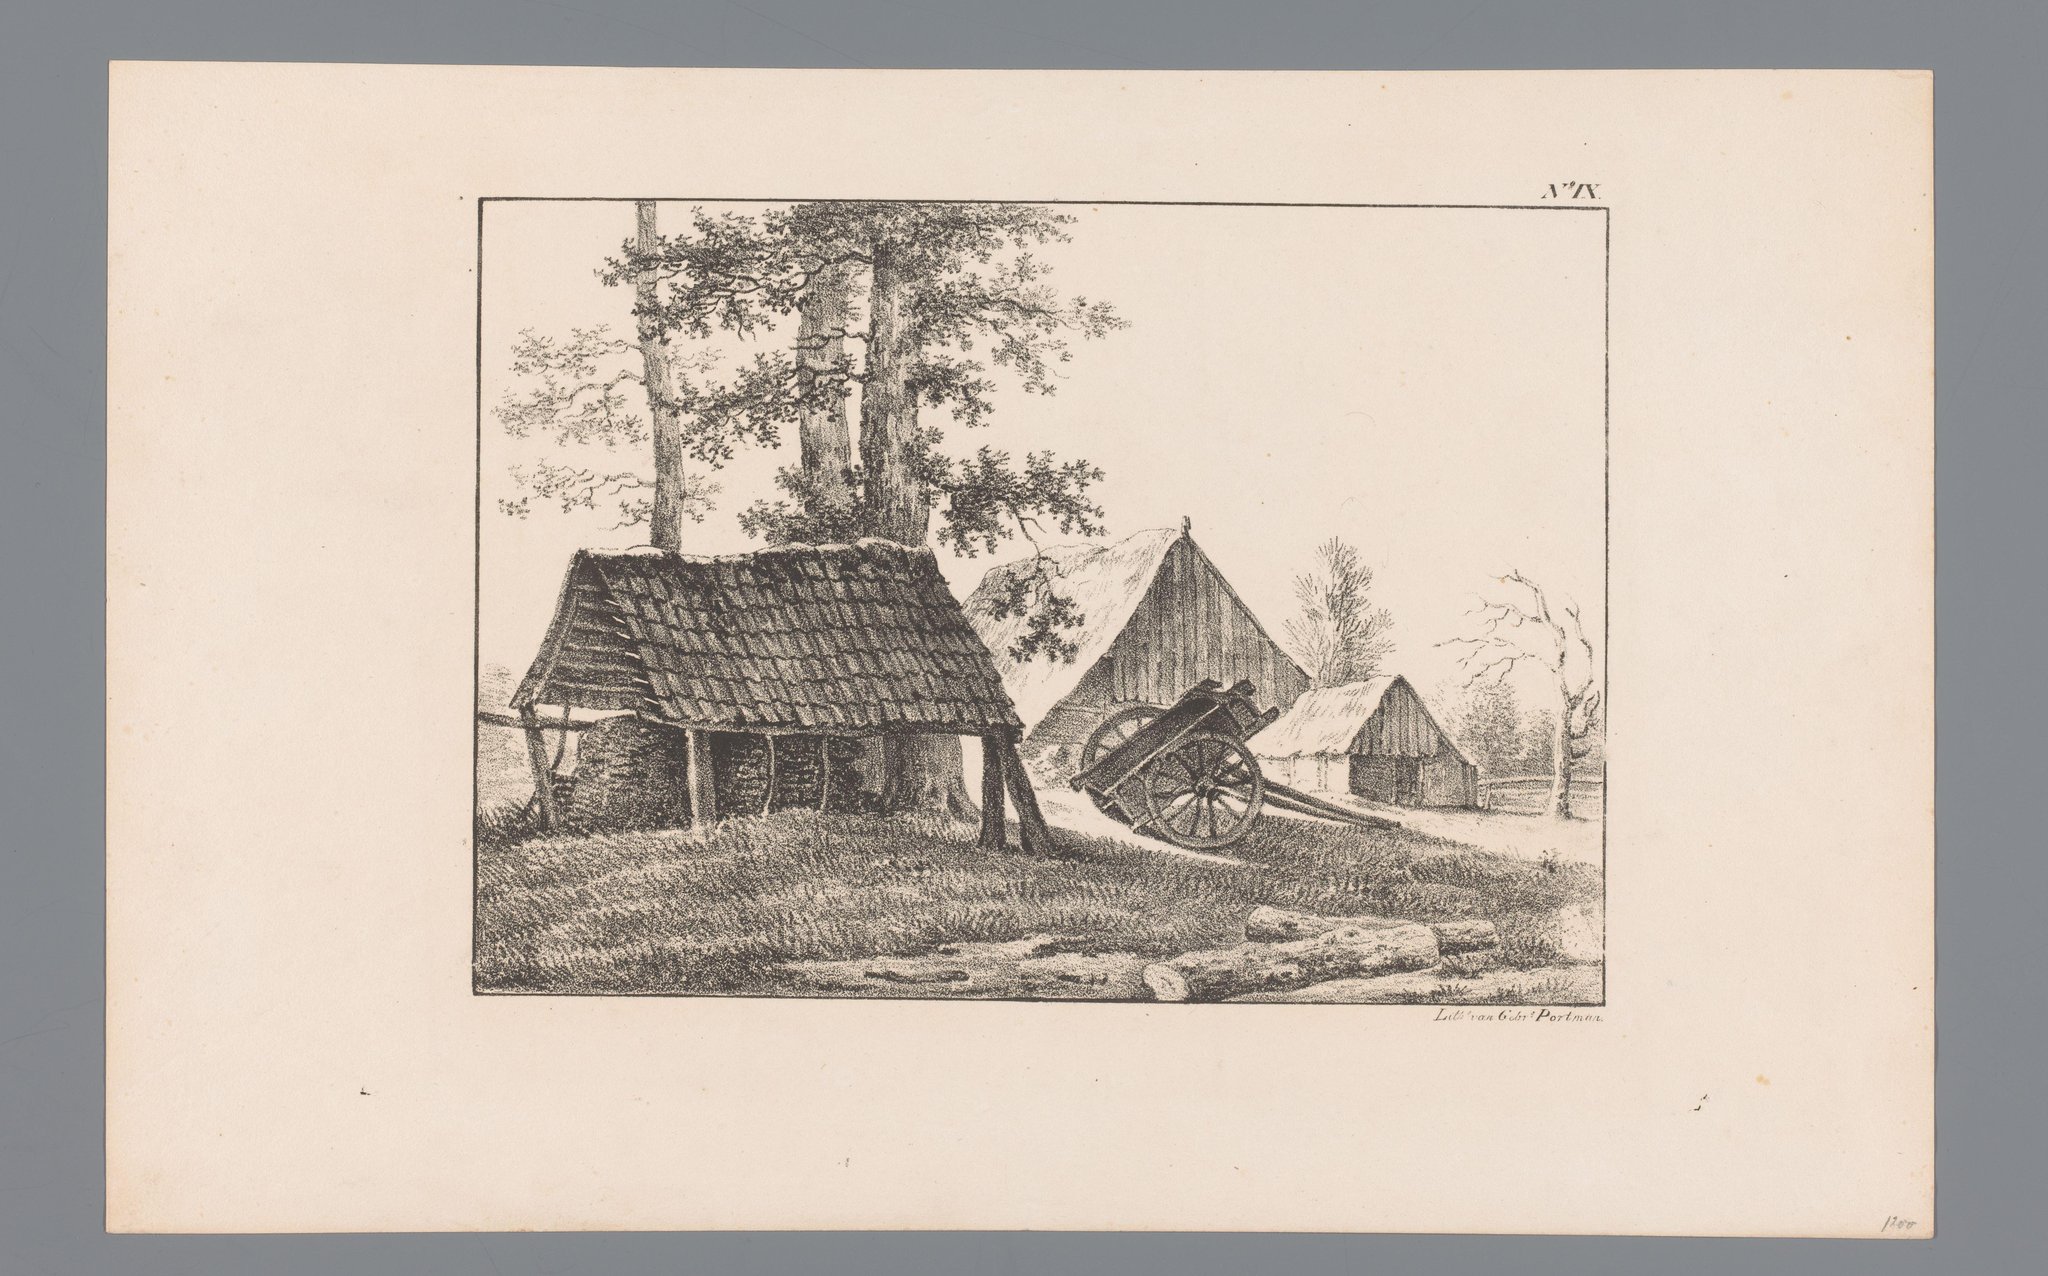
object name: print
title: Landschapstudien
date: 1809-1845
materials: paper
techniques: lithograph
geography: amsterdam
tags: barn, shed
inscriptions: collector's mark: Lugt 2228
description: Een afdak en een kar met twee wielen voor een boerenschuur in de achtergrond. Onderdeel van een omslag met een serie van zes landschappen.